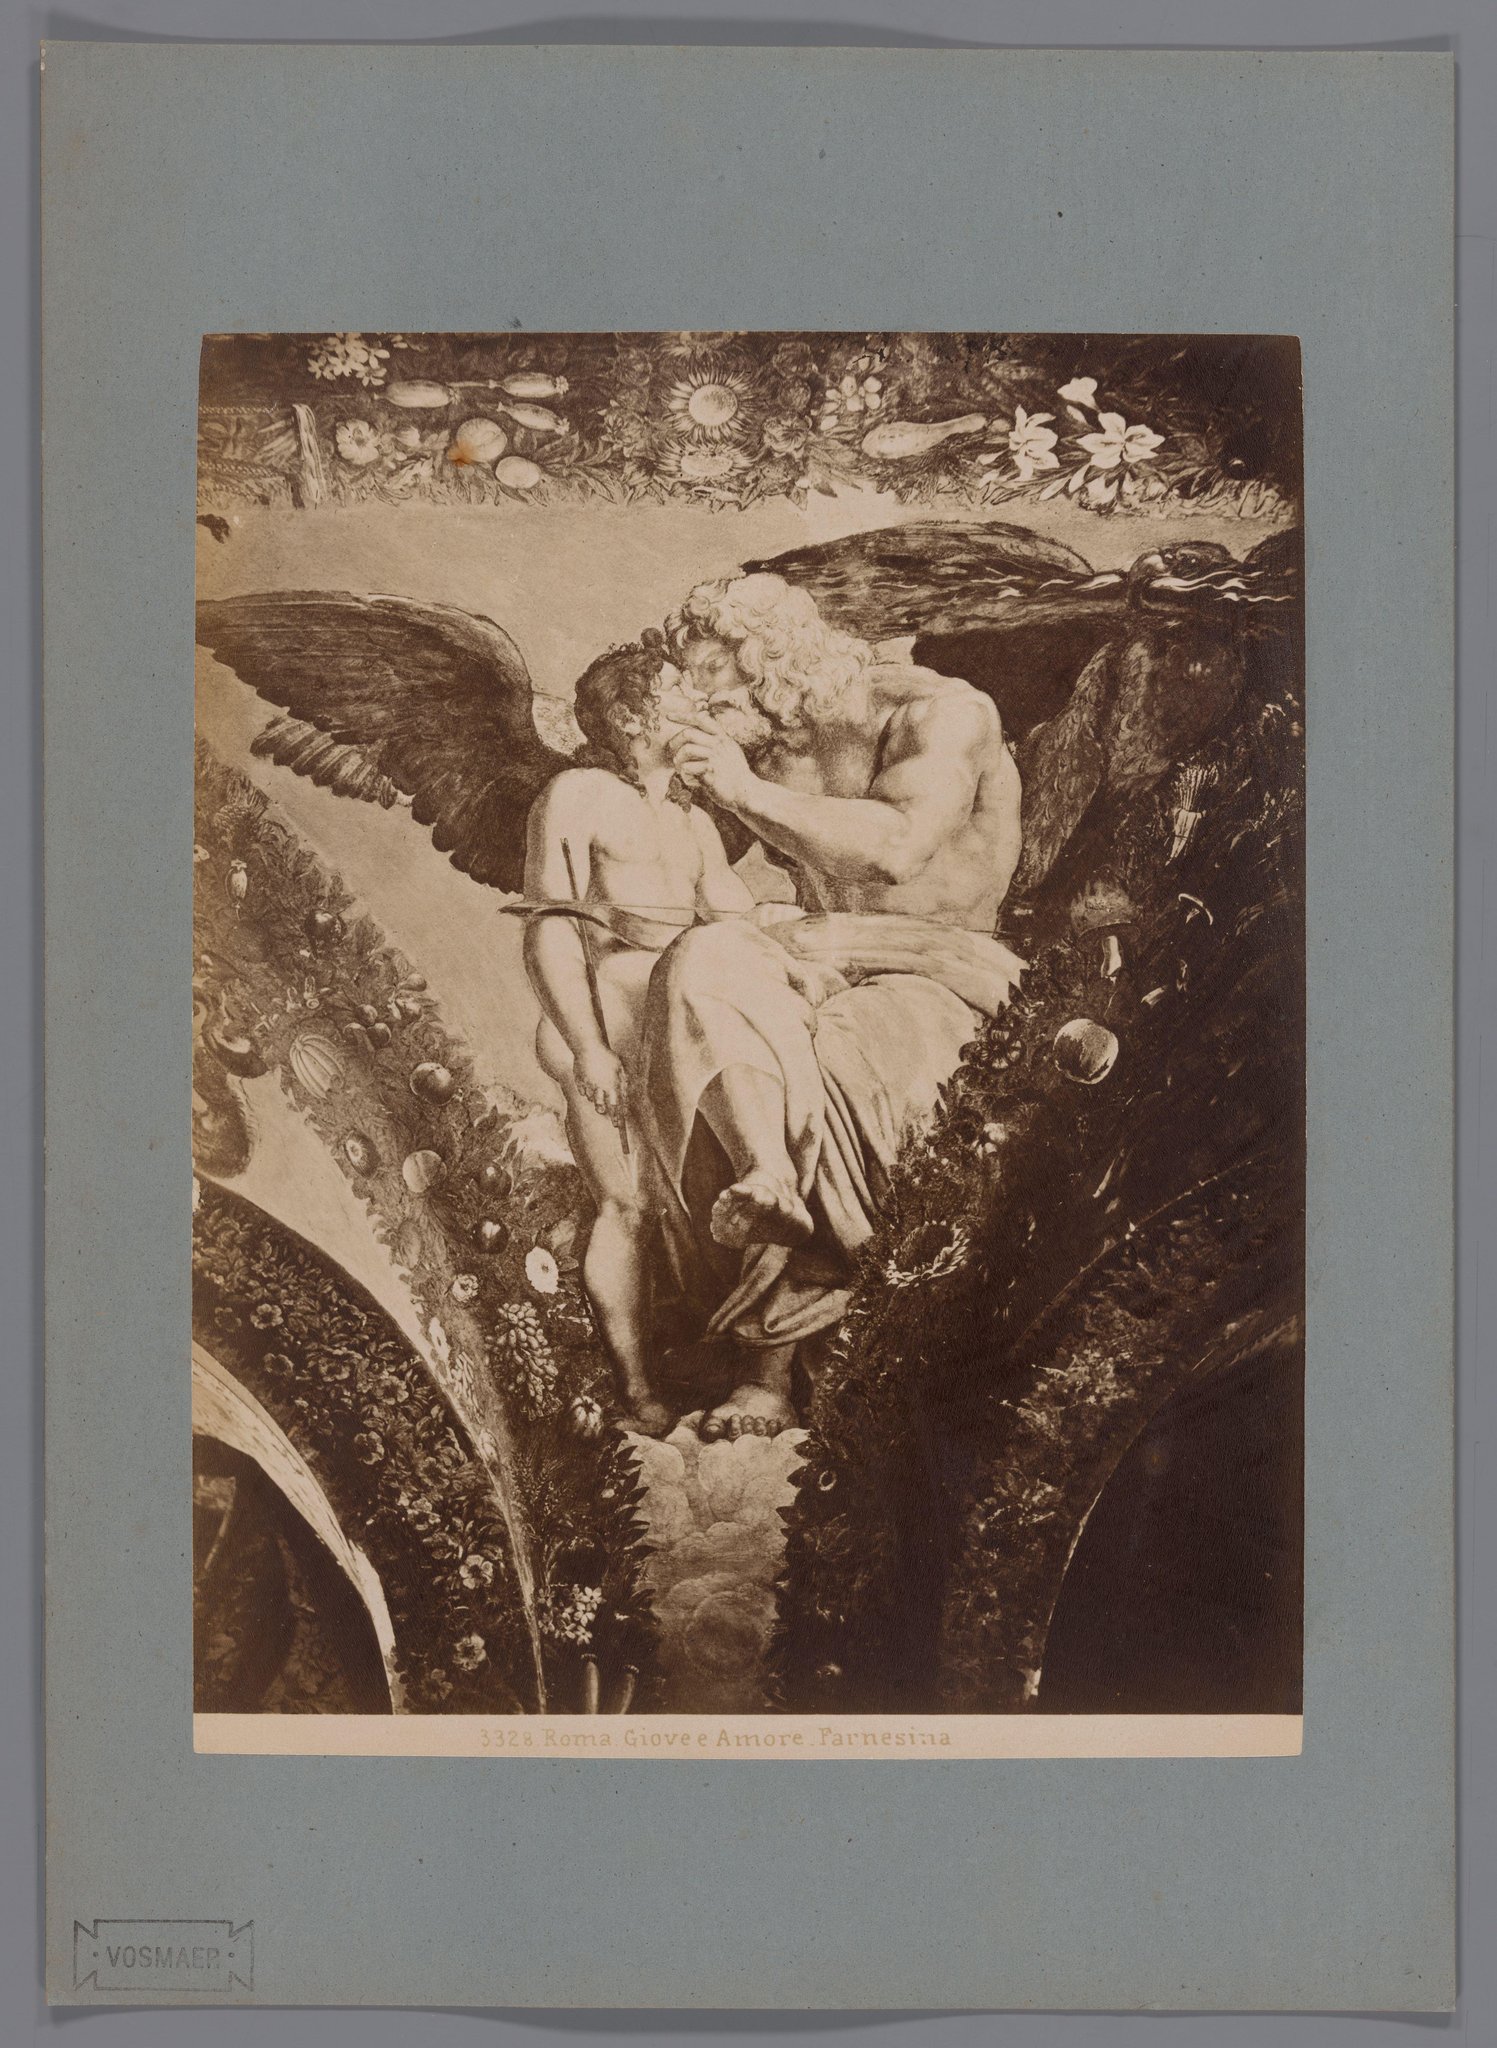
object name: photograph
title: Fotoreproductie van het fresco Jupiter en Amor in de Loggia di Psiche, Villa Farnesina te Rome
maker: Anonymous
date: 1851-1900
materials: cardboard, paper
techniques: albumen print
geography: rome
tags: picture, painting, rome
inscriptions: number: ‘3328.’, collector's mark: ‘VOSMAER’